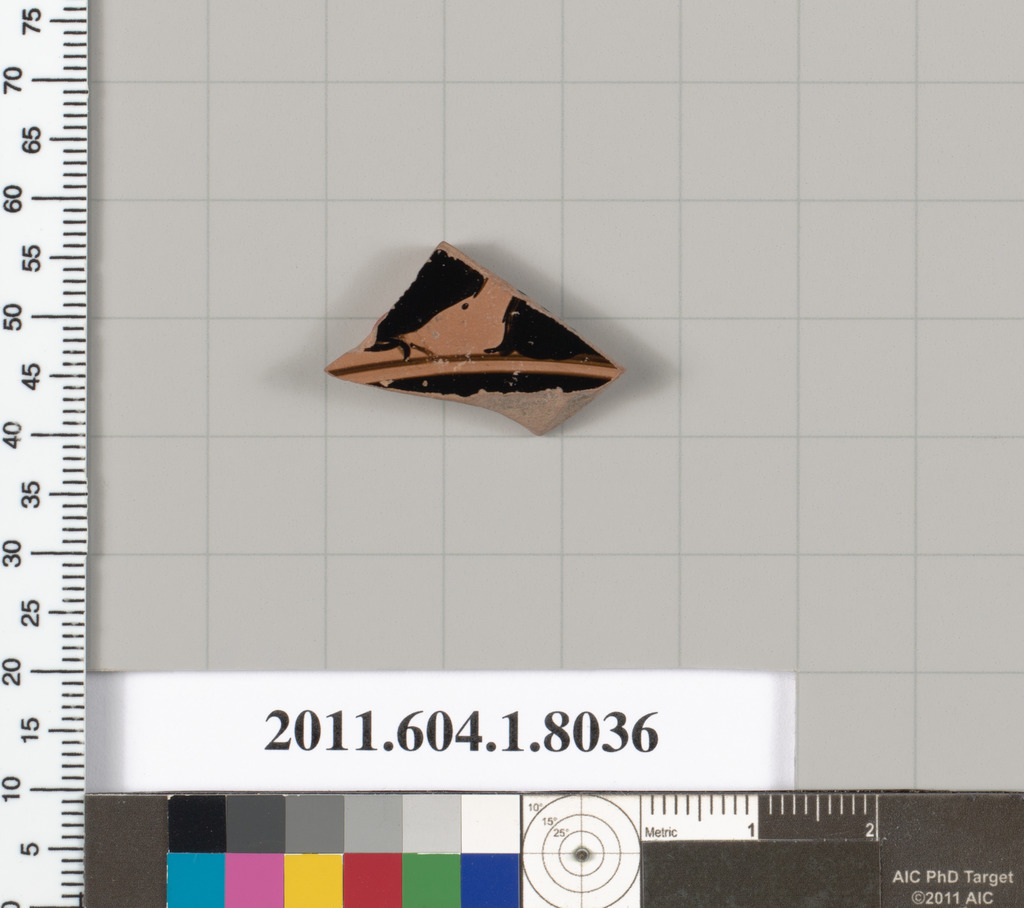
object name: kylix fragment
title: Terracotta fragment of a kylix (drinking cup)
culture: greek, attic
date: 510-500 BCE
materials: terracotta